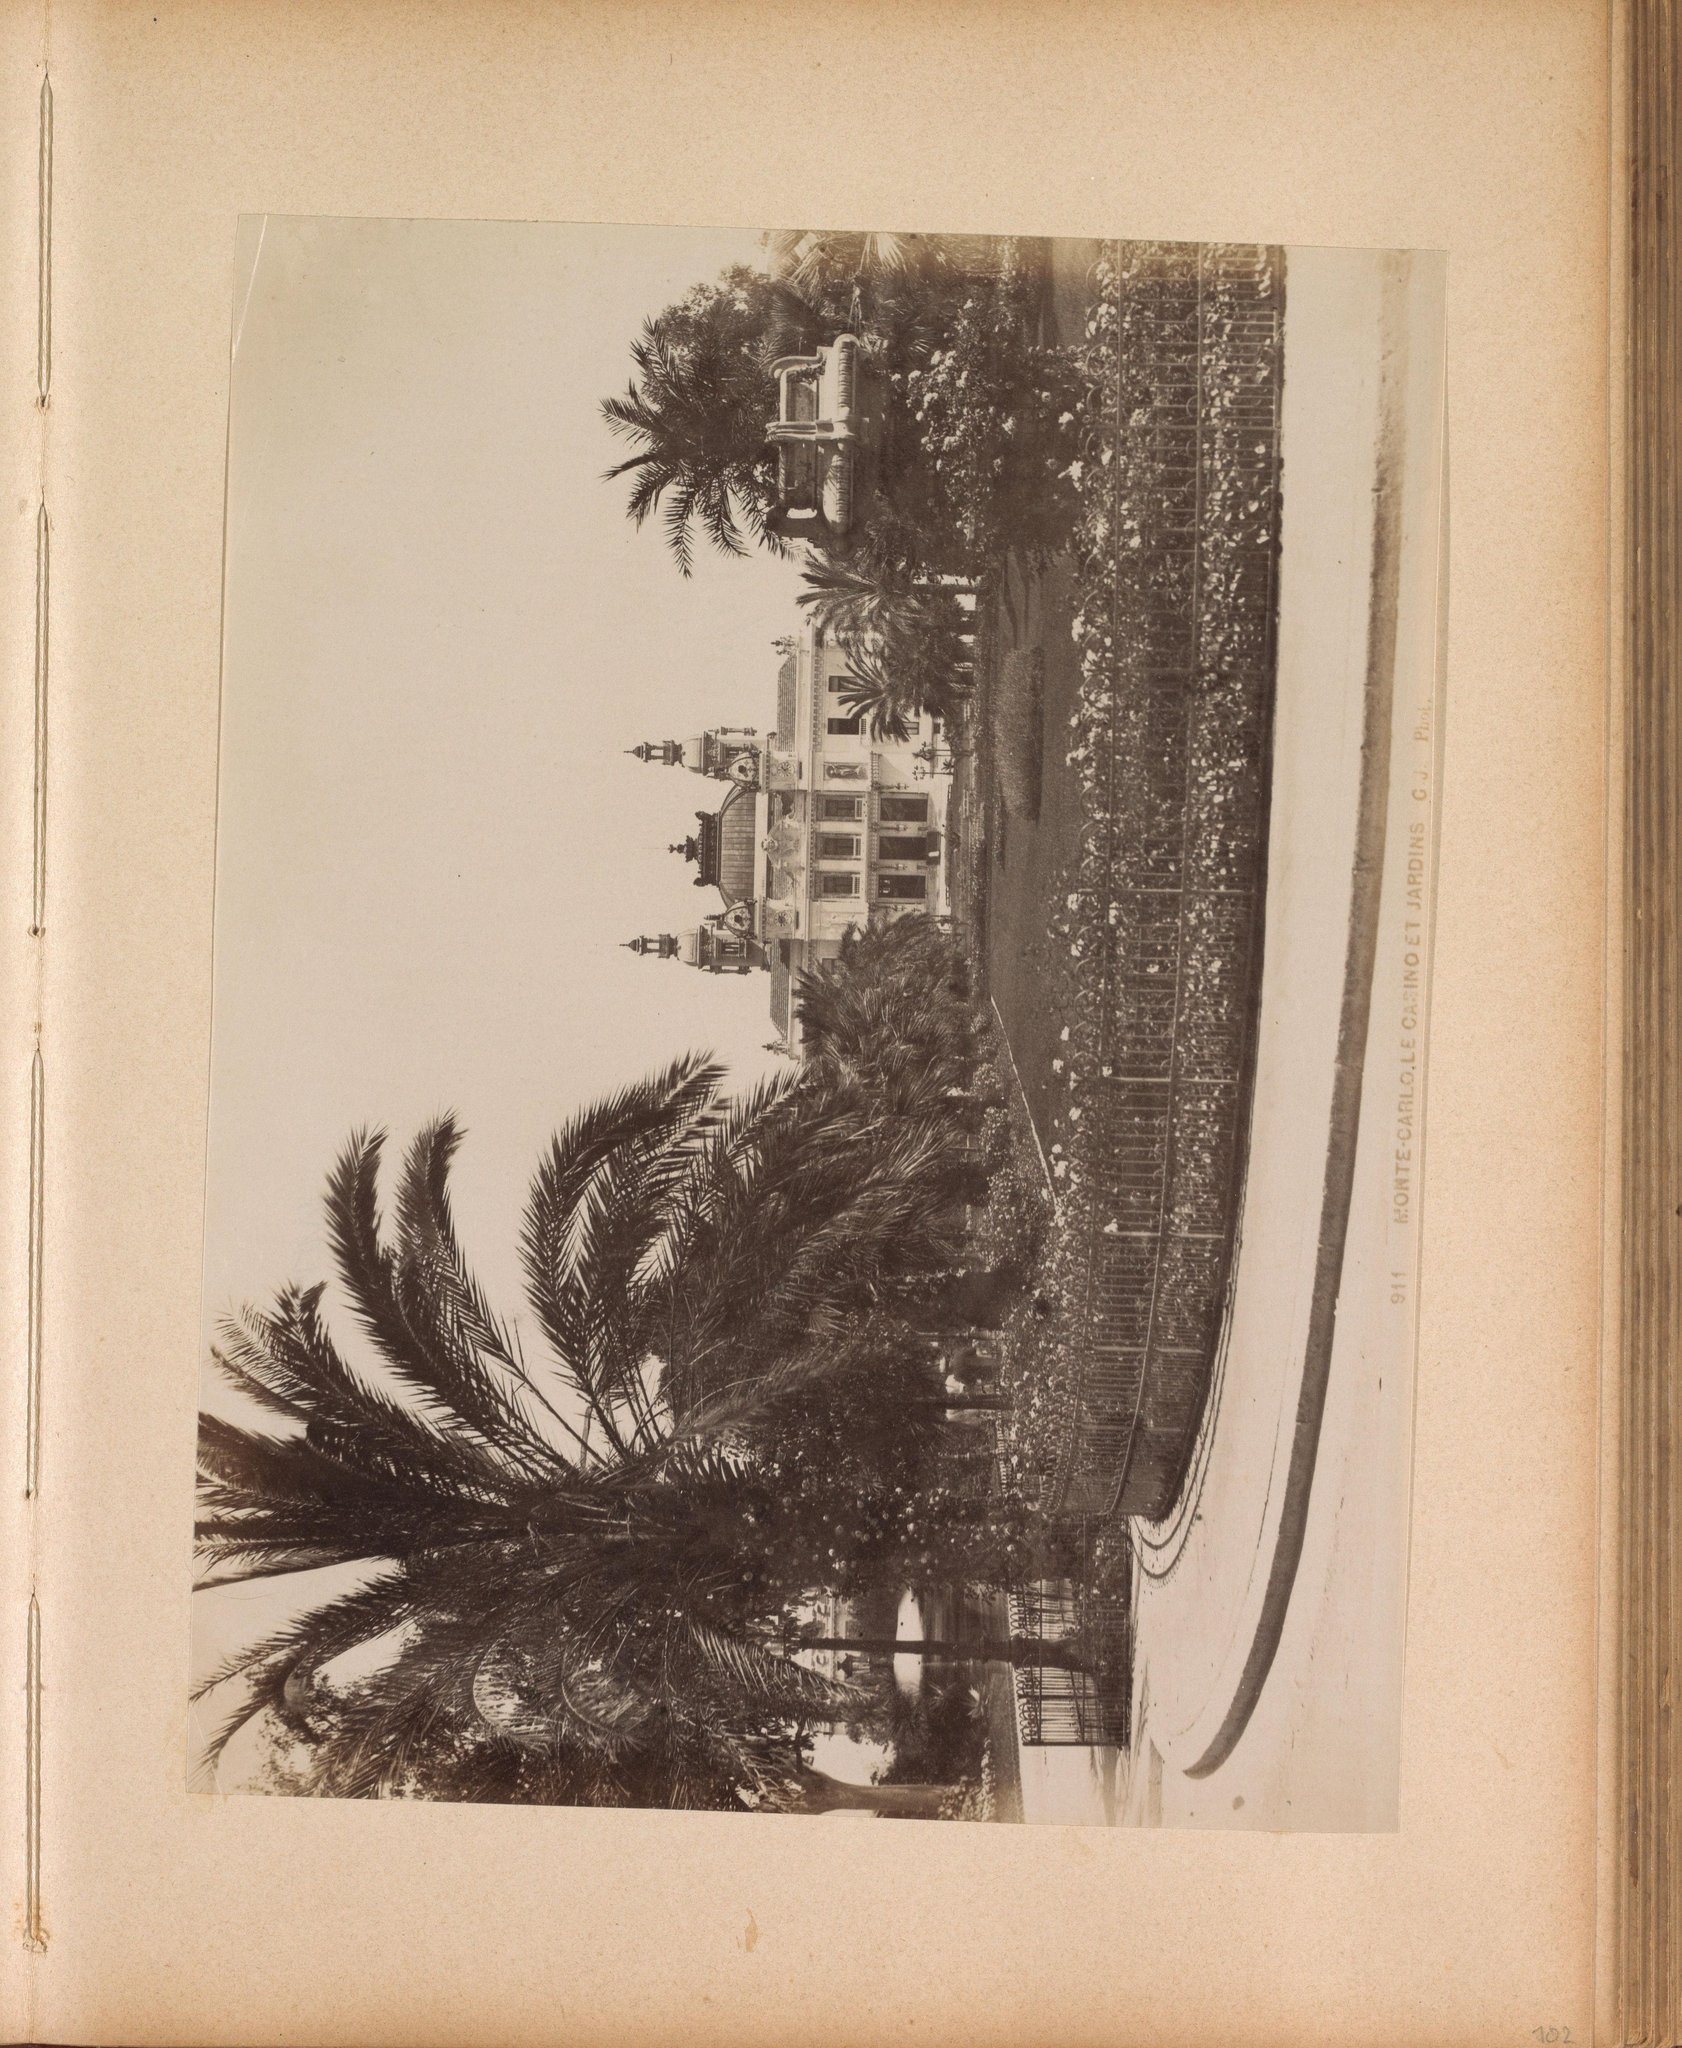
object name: album leaf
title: Monte-Carlo. La casino et les jardins.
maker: jean gilletta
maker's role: fotograaf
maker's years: 1856-1933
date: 1870-1900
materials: paper, photographic support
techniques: albumen print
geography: monaco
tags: trees: palm-tree, casino, public gardens, park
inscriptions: negative number: ‘911’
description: Onderdeel van Reisalbum met foto's van bezienswaardigheden in Italië en Zuid-Frankrijk.